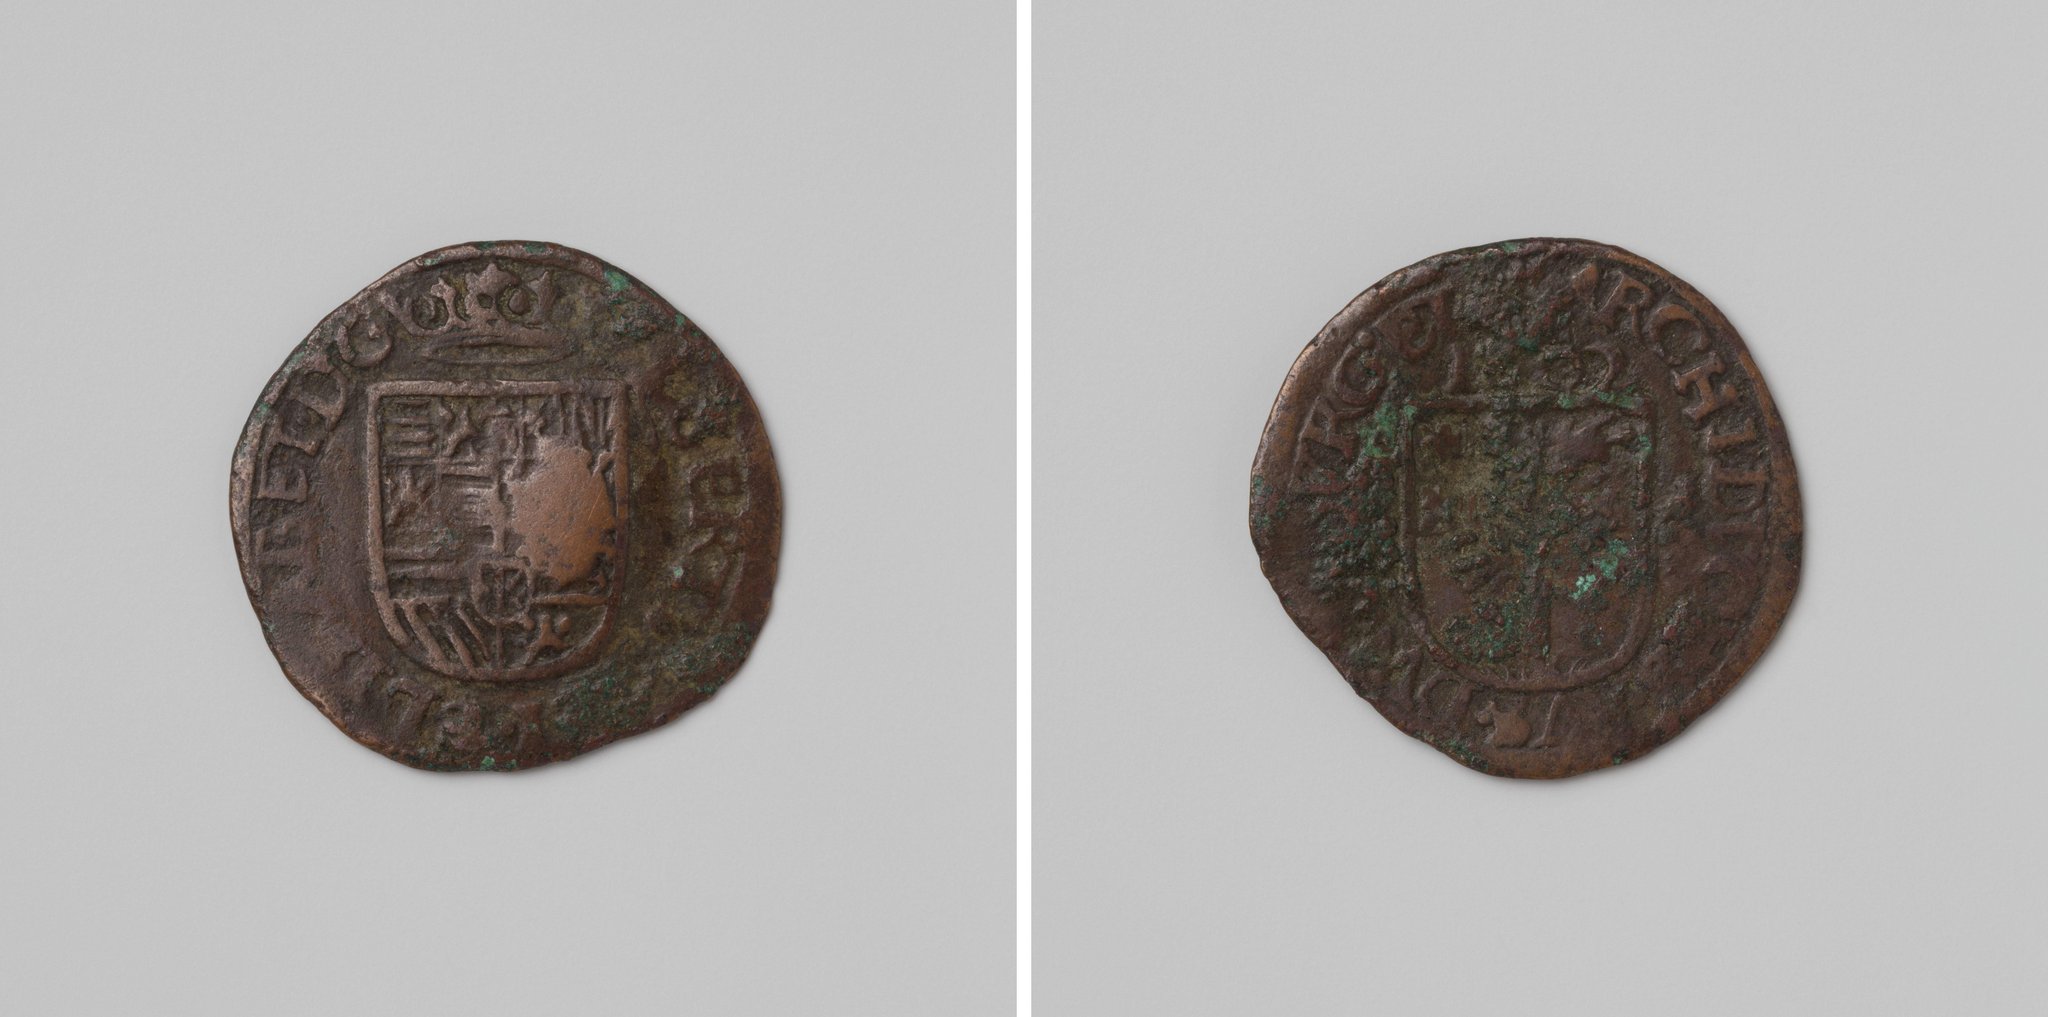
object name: jeton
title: Maurits, graaf van Nassau, breekt het beleg van 's-Hertogenbosch af, rekenpenning ter ere van Albrecht en Isabella van Oostenrijk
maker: Anonymous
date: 1602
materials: copper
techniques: striking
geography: den bosch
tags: the hague, maurice (prince of orange), infante van spanje isabella clara eugenia, brussels, albrecht aartshertog van oostenrijk, den bosch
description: Koperen penning. Voorzijde: gekroond wapenschild binnen omschrift. Keerzijde: wapenschild onder jaartal binnen omschrift